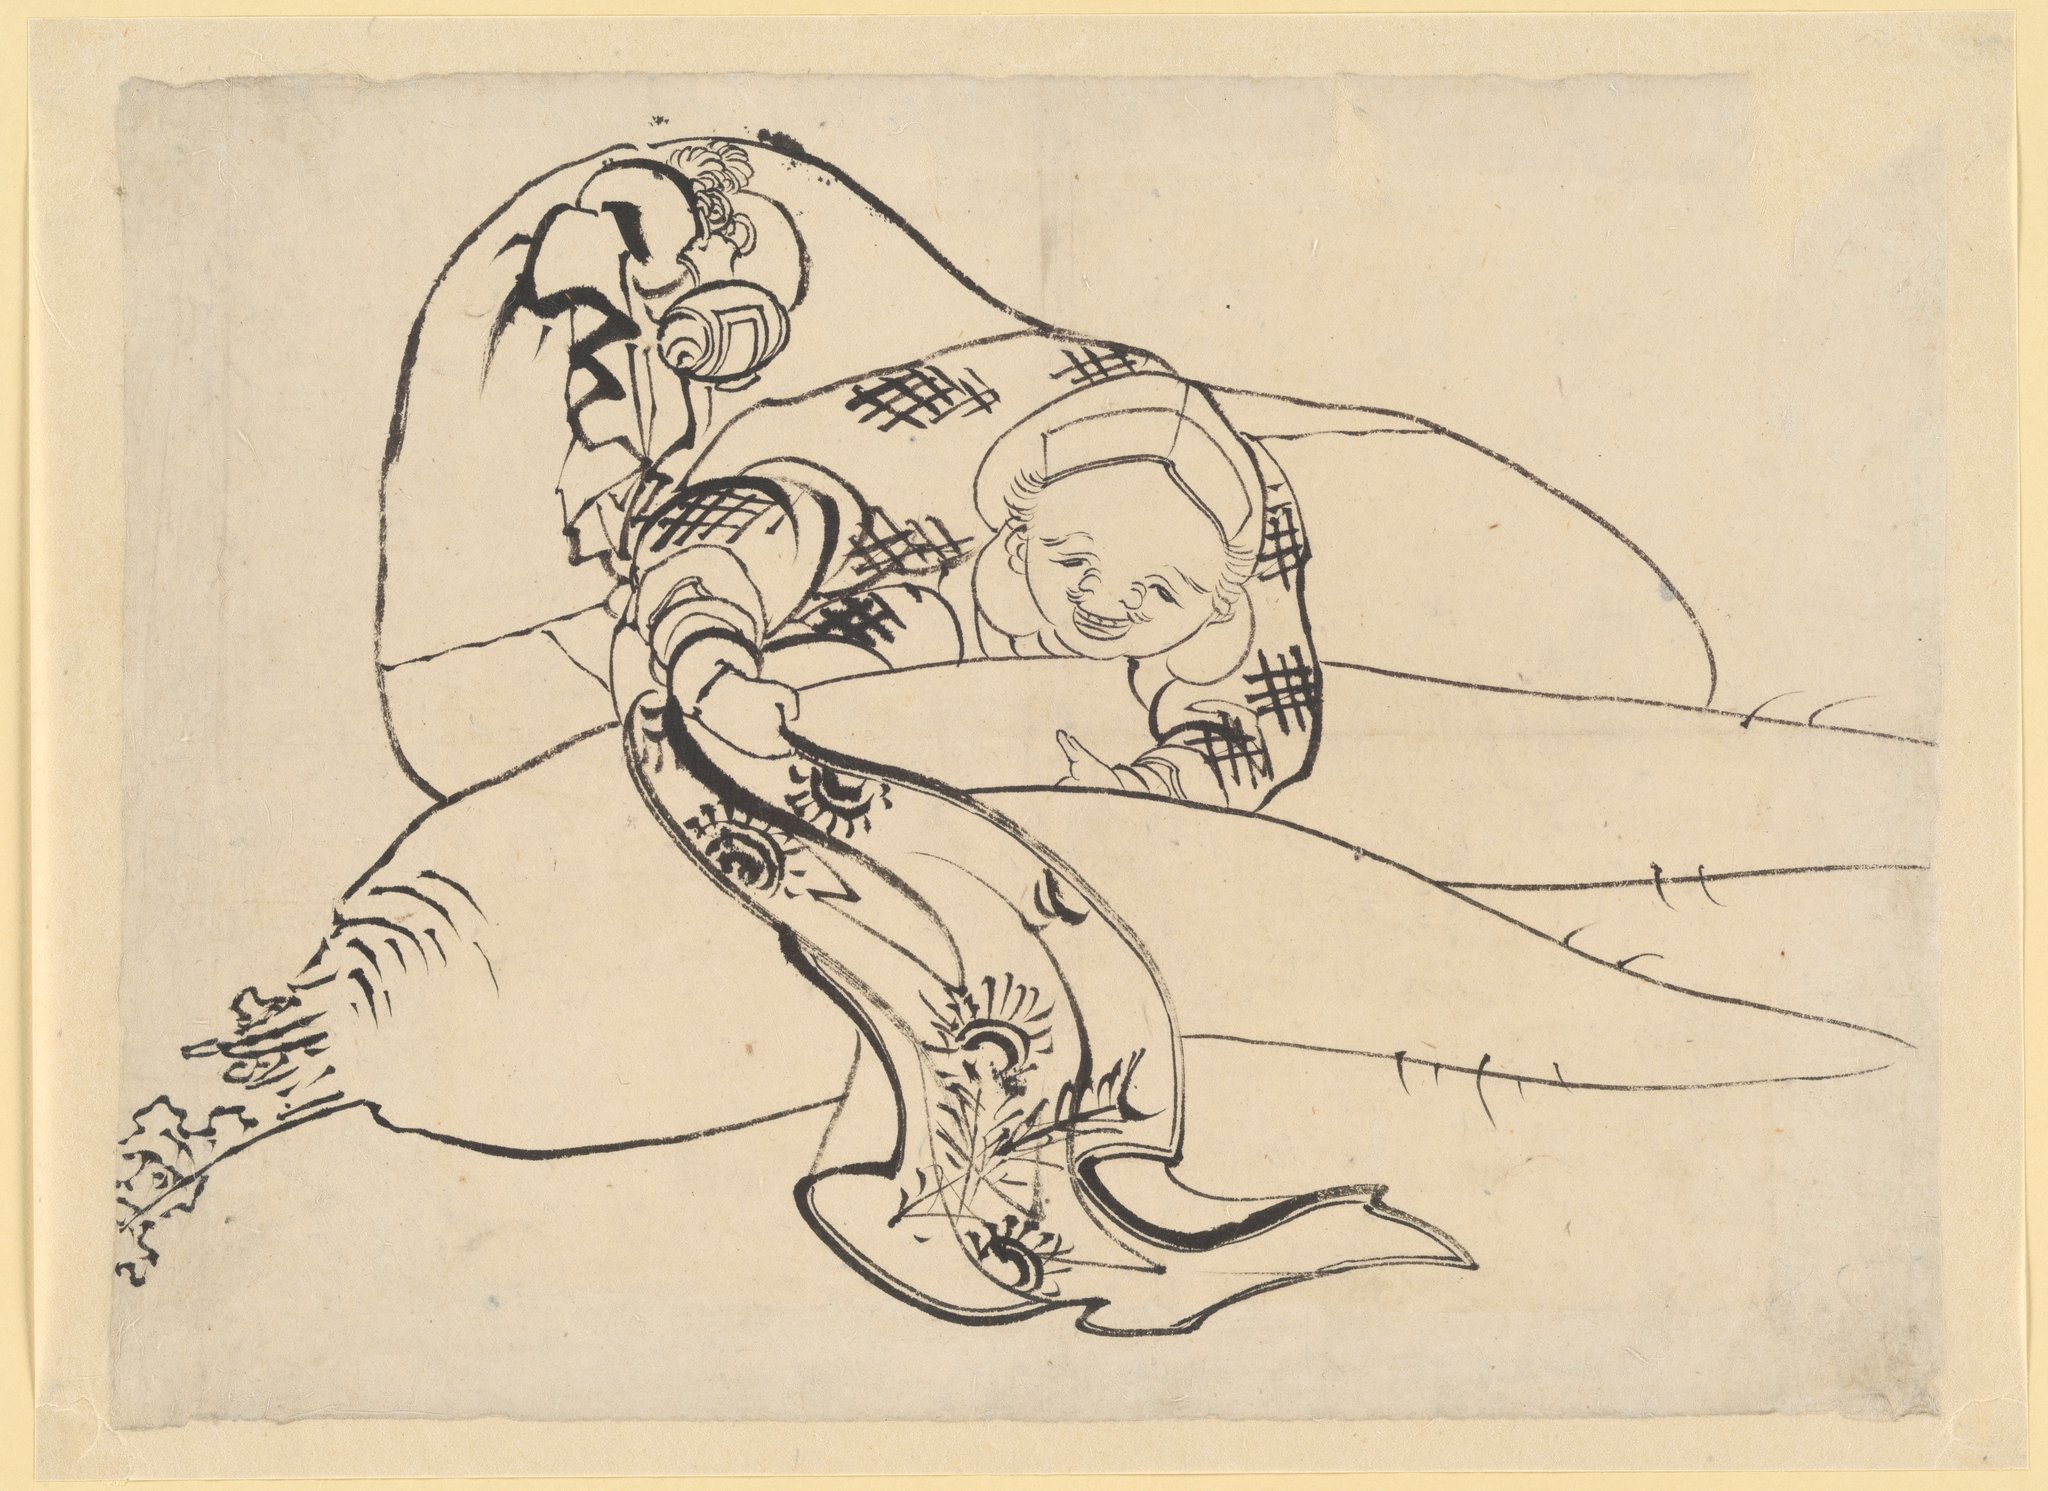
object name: drawing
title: Daikoku (God of Luck) with Radish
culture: japanese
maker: katsushika hokusai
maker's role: artist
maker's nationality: japanese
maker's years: 1760-1849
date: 1701-1900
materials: ink, paper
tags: vegetables